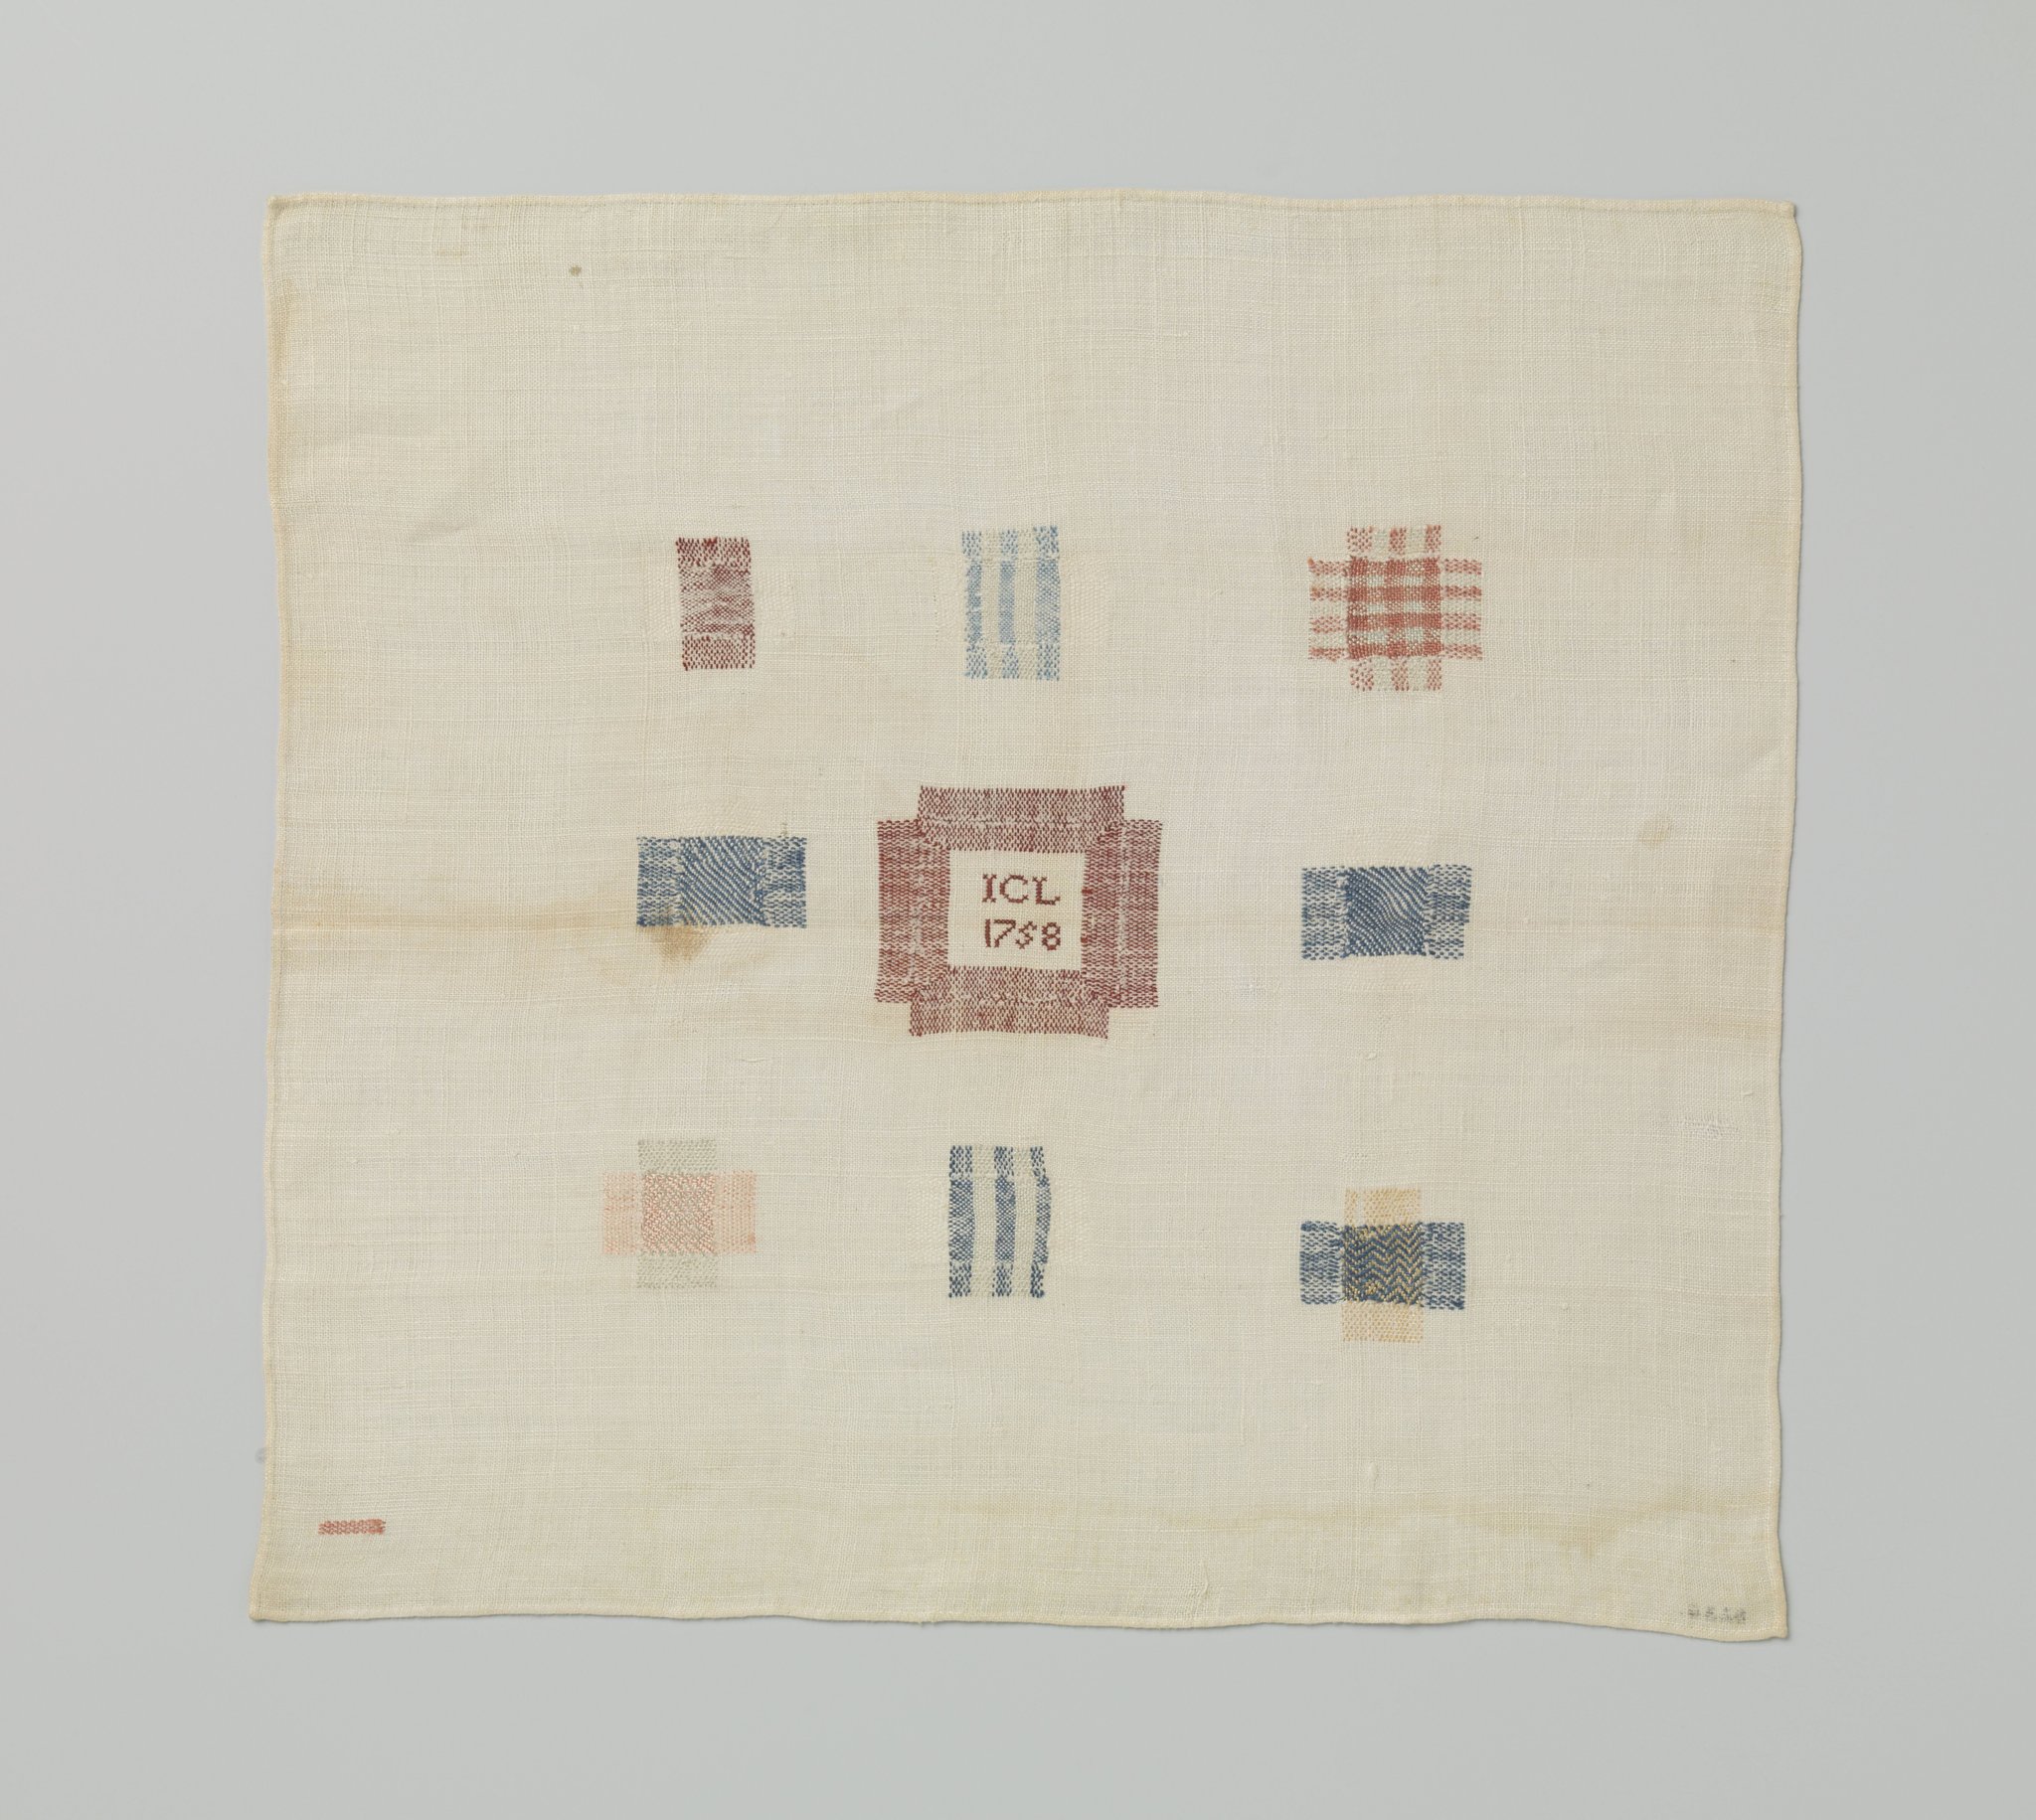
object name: stoplap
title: Stoplap van linnen, met veelkleurig borduurwerk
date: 1758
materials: linen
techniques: embroidered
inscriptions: date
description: Stoplap met borduurwerk. Het borduurwerk heeft het jaartal 1758 en de initialen ICL in een vierkant, met daar omheen diverse stoppen.